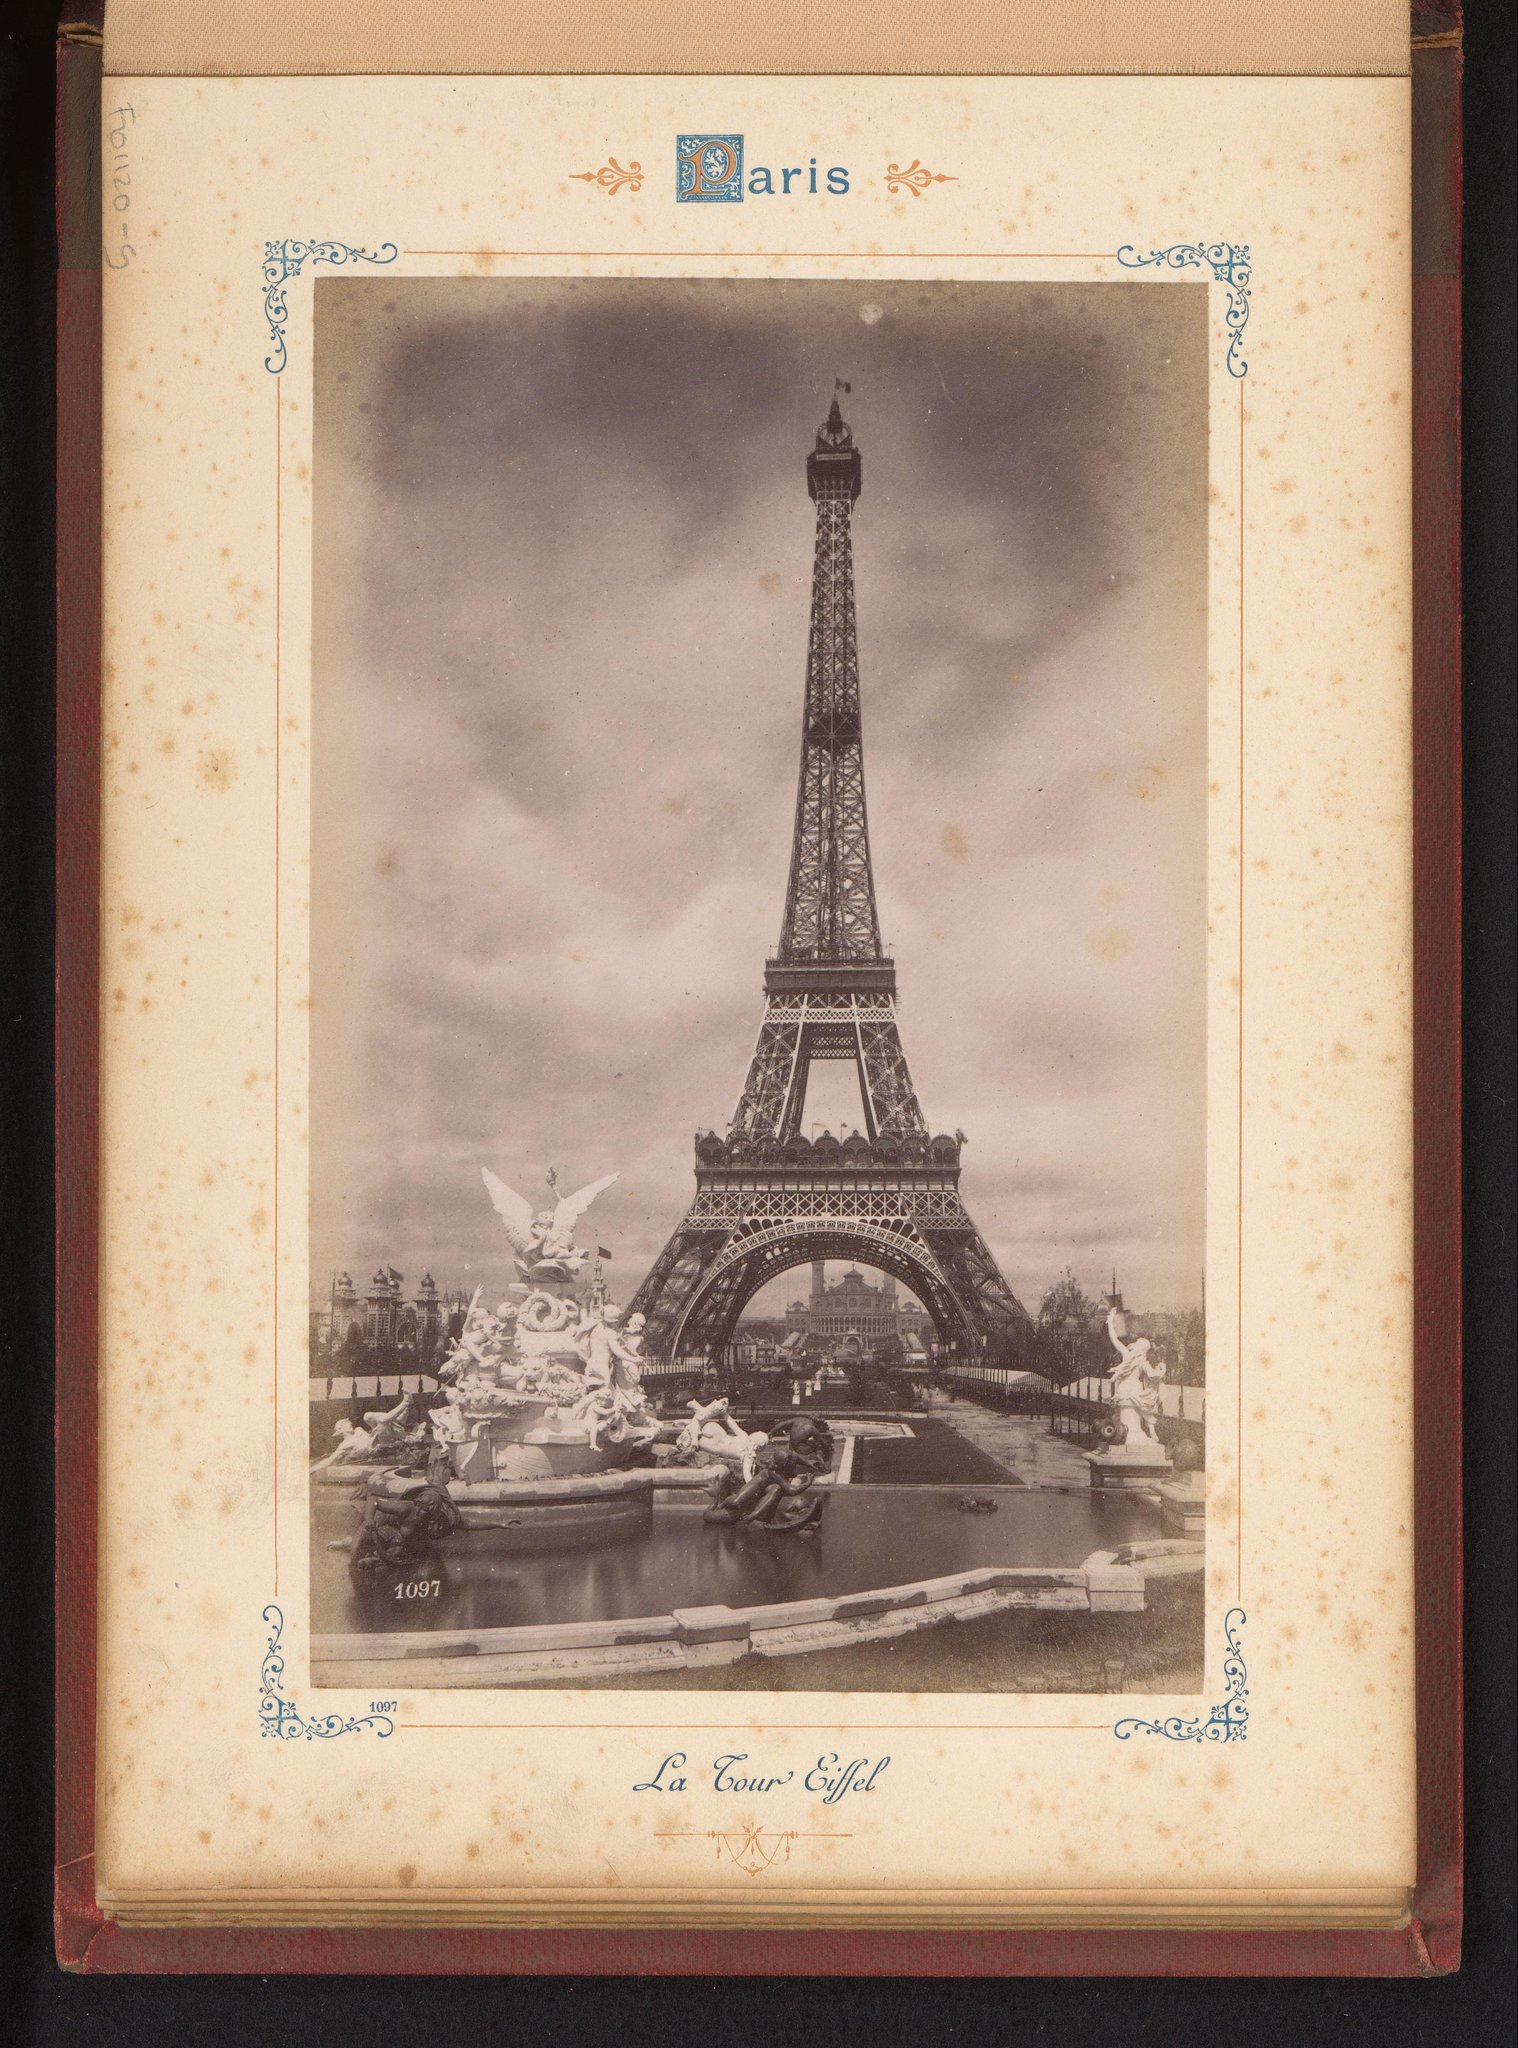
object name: photograph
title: Gezicht op de Eiffeltoren met op de achtergrond Palais du Trocadéro te Parijs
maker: Anonymous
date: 1889-1900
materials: cardboard, photographic support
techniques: albumen print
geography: paris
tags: tower, clock tower ~ monumental adornment, world fair, world exhibition, ornamental fountain, eiffel tower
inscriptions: number: ‘1097’, number: ‘1097’